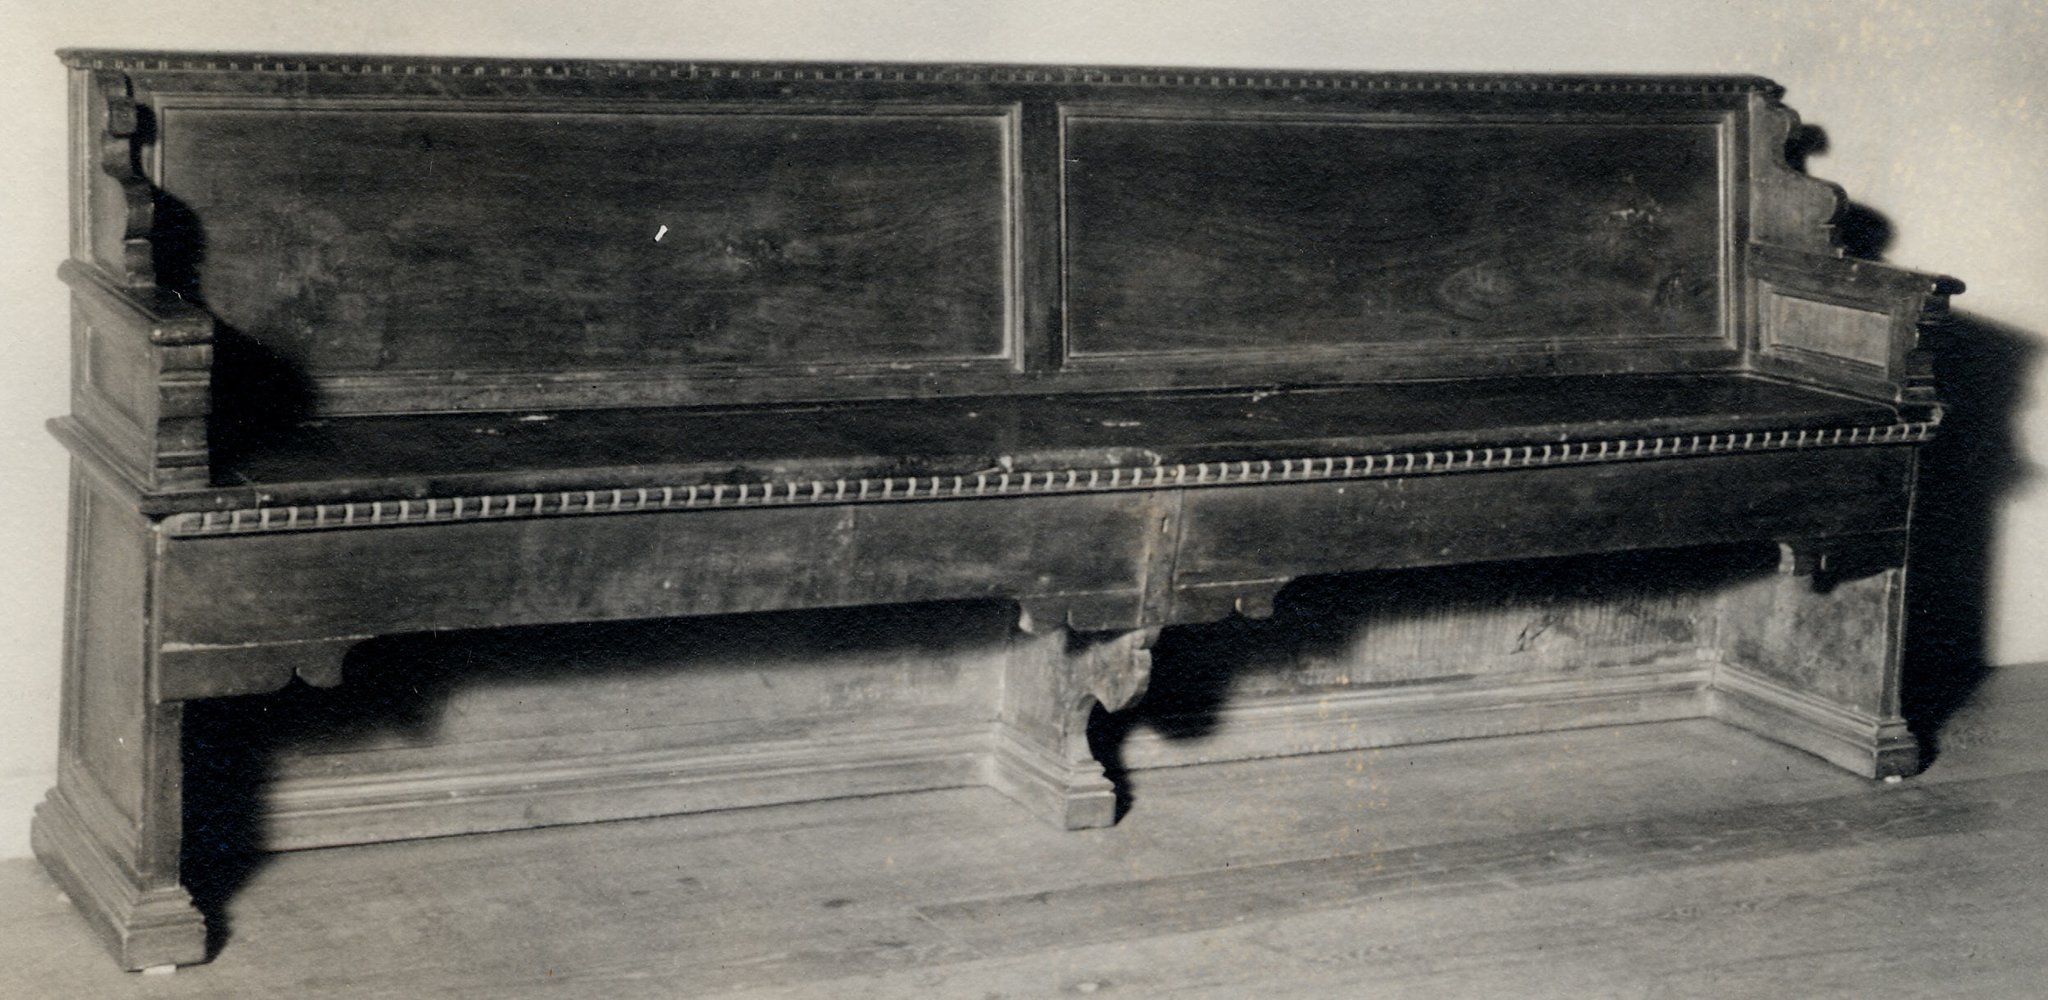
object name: bench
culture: italian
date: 1501-1600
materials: wood